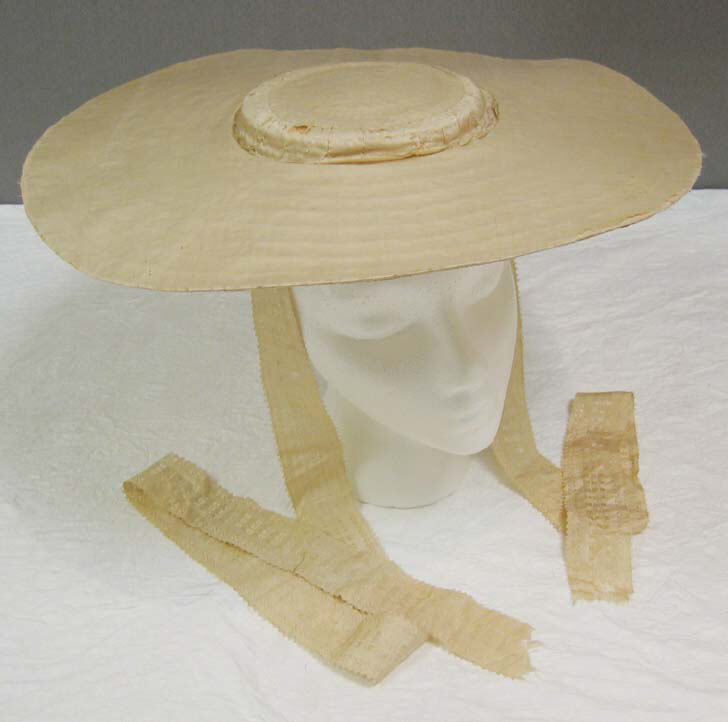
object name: hat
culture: italian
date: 1720-1750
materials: silk